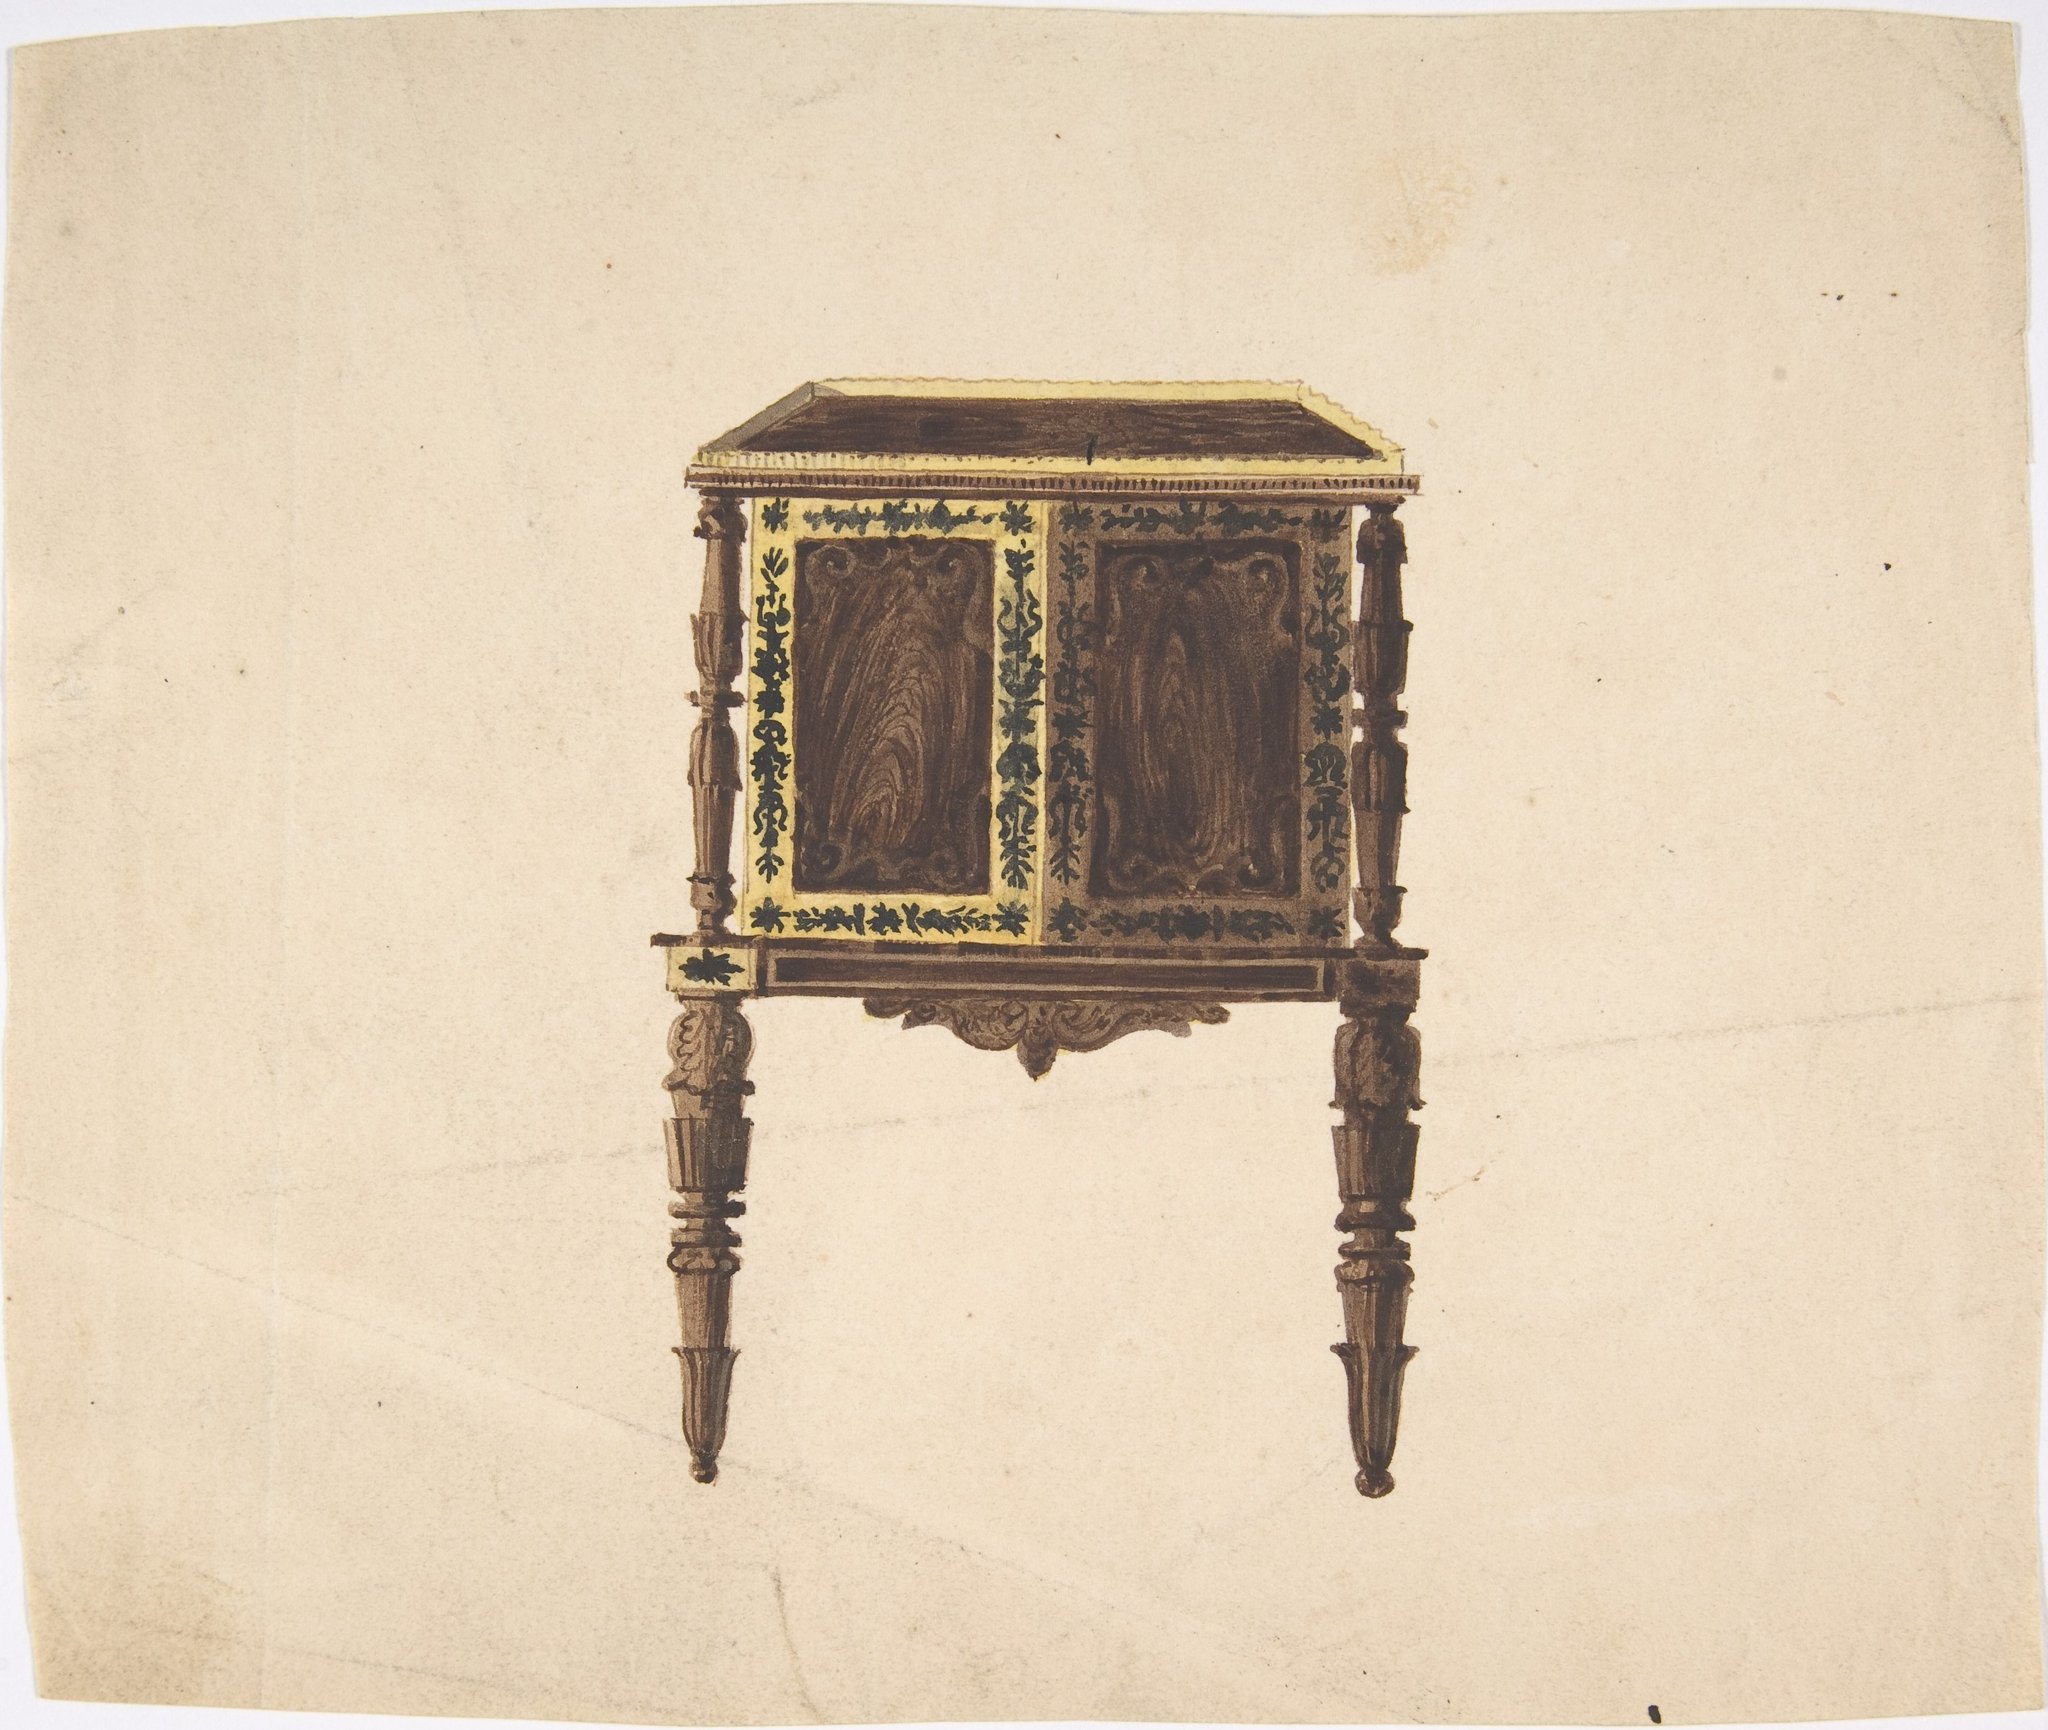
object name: drawing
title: Design for a Small Cabinet with Elaborately Carved Legs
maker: anonymous, british, 19th century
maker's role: artist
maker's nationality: british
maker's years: 1800-1900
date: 1801-1833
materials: ink, watercolor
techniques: pen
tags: cabinets